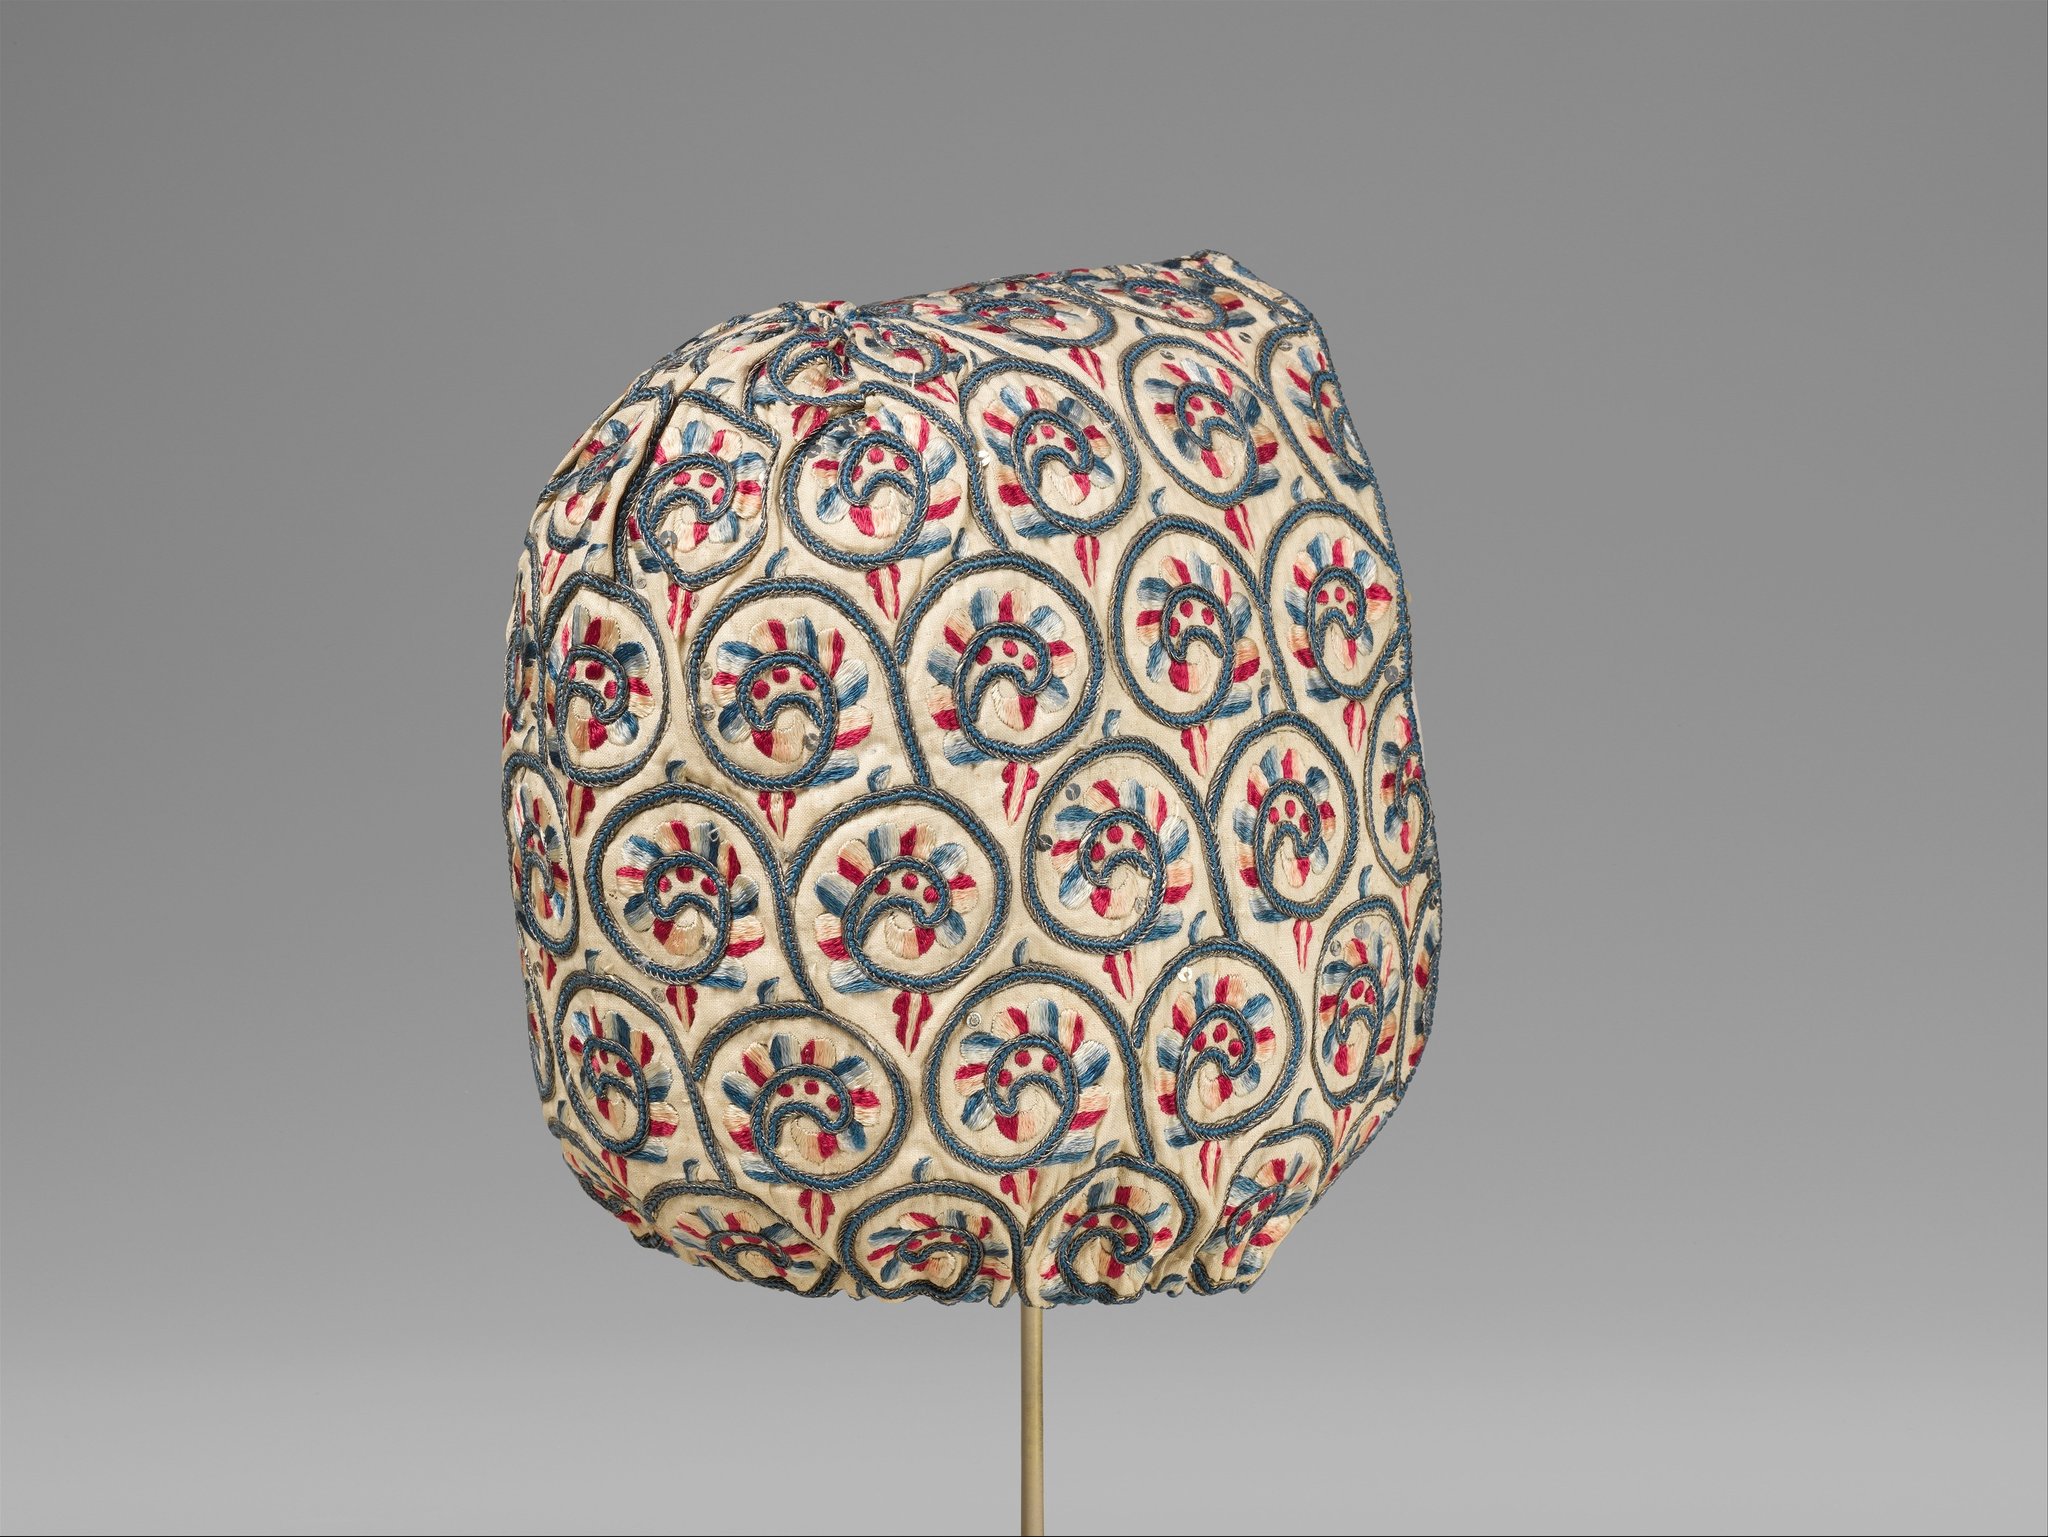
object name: coif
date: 1600-1630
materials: linen, metal thread, textile, silk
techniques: embroidery, stitching